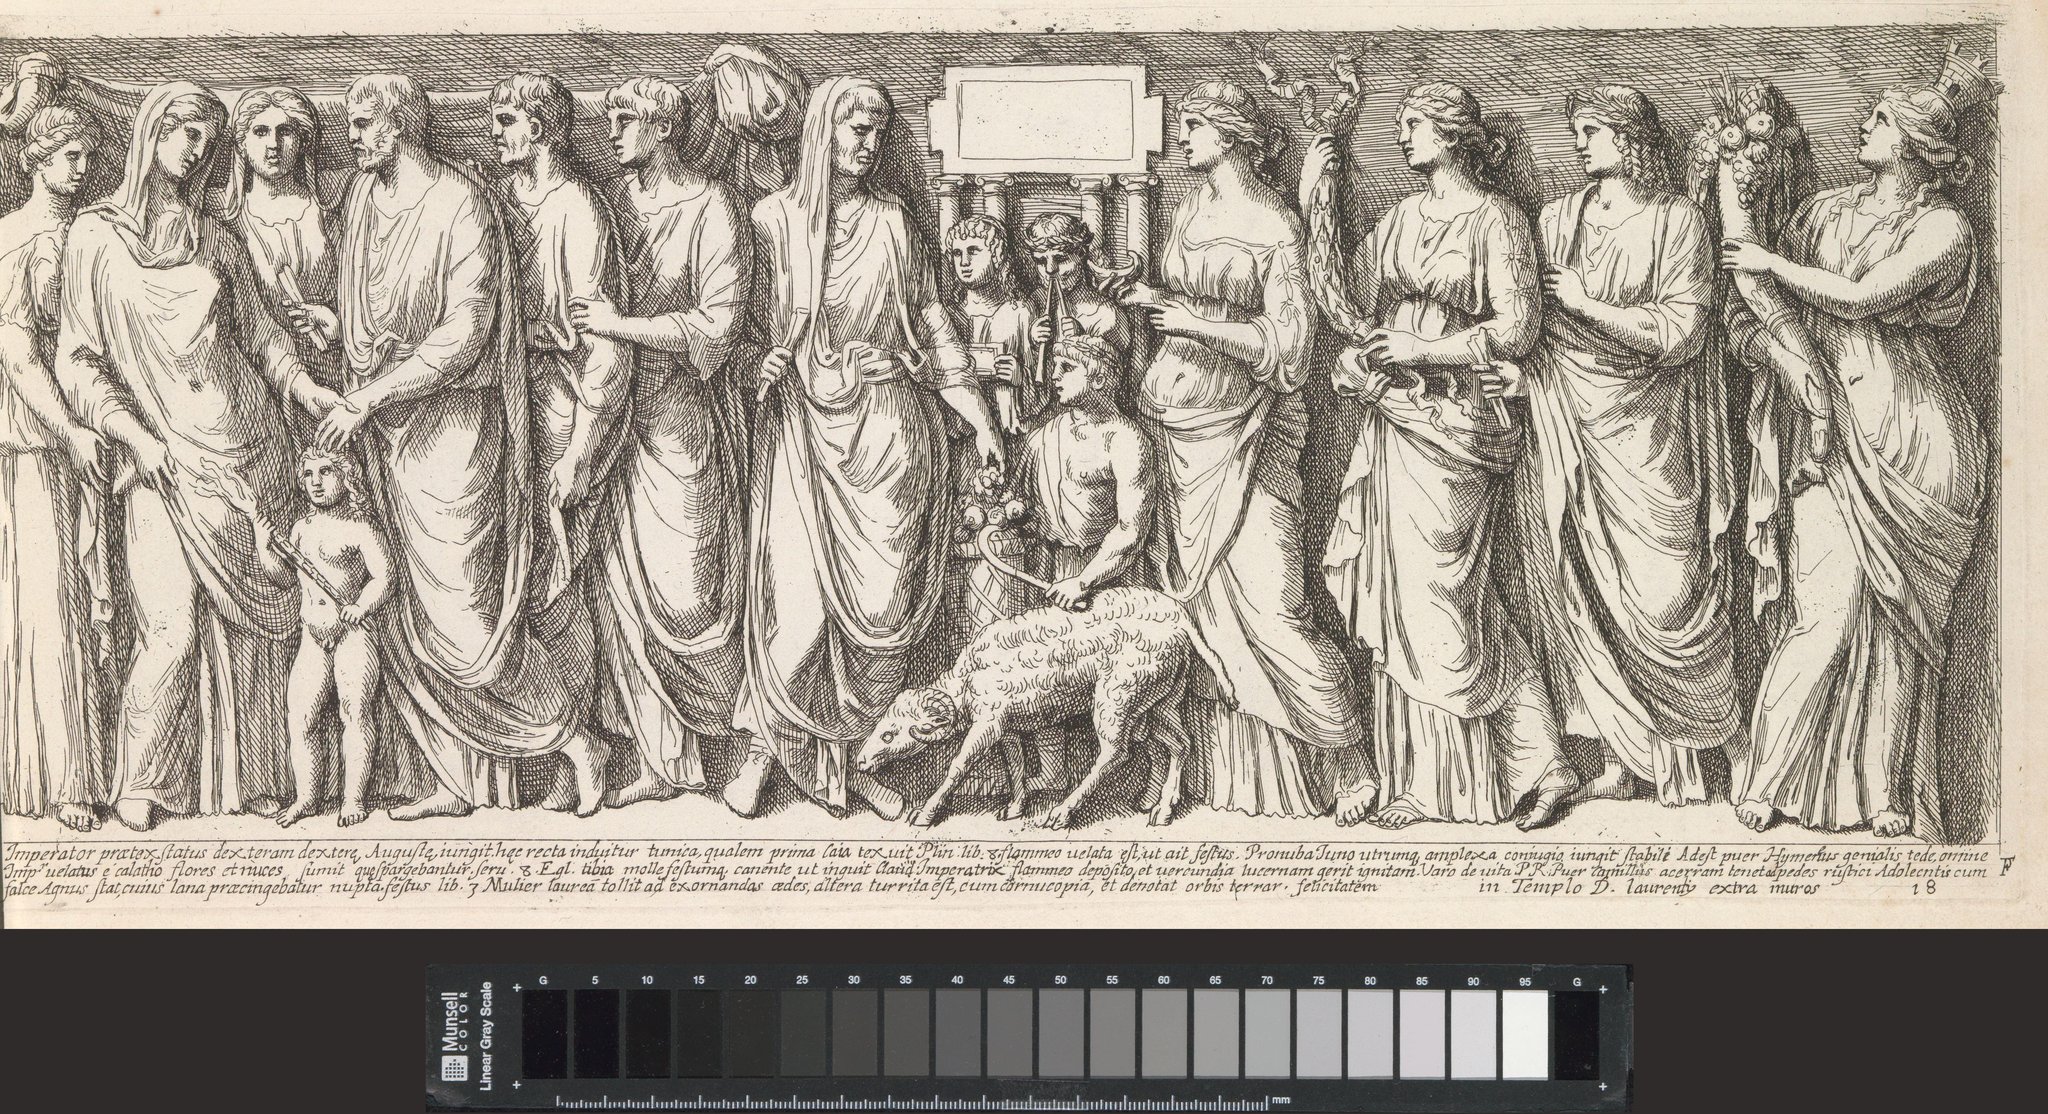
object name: album leaf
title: Romeinse gebeeldhouwde reliëfs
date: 1645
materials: paper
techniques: etching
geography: paris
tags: civil marriage ceremony, piece of sculpture, reproduction of a piece of sculpture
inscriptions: number: ‘45’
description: Deze prent maakt deel uit van een reeks van 54 prenten (+ titelprent) naar antieke reliëfs. De nummering op de prenten loopt van 1 tot en met 50. Sommige prenten hebben dubbele nummers.